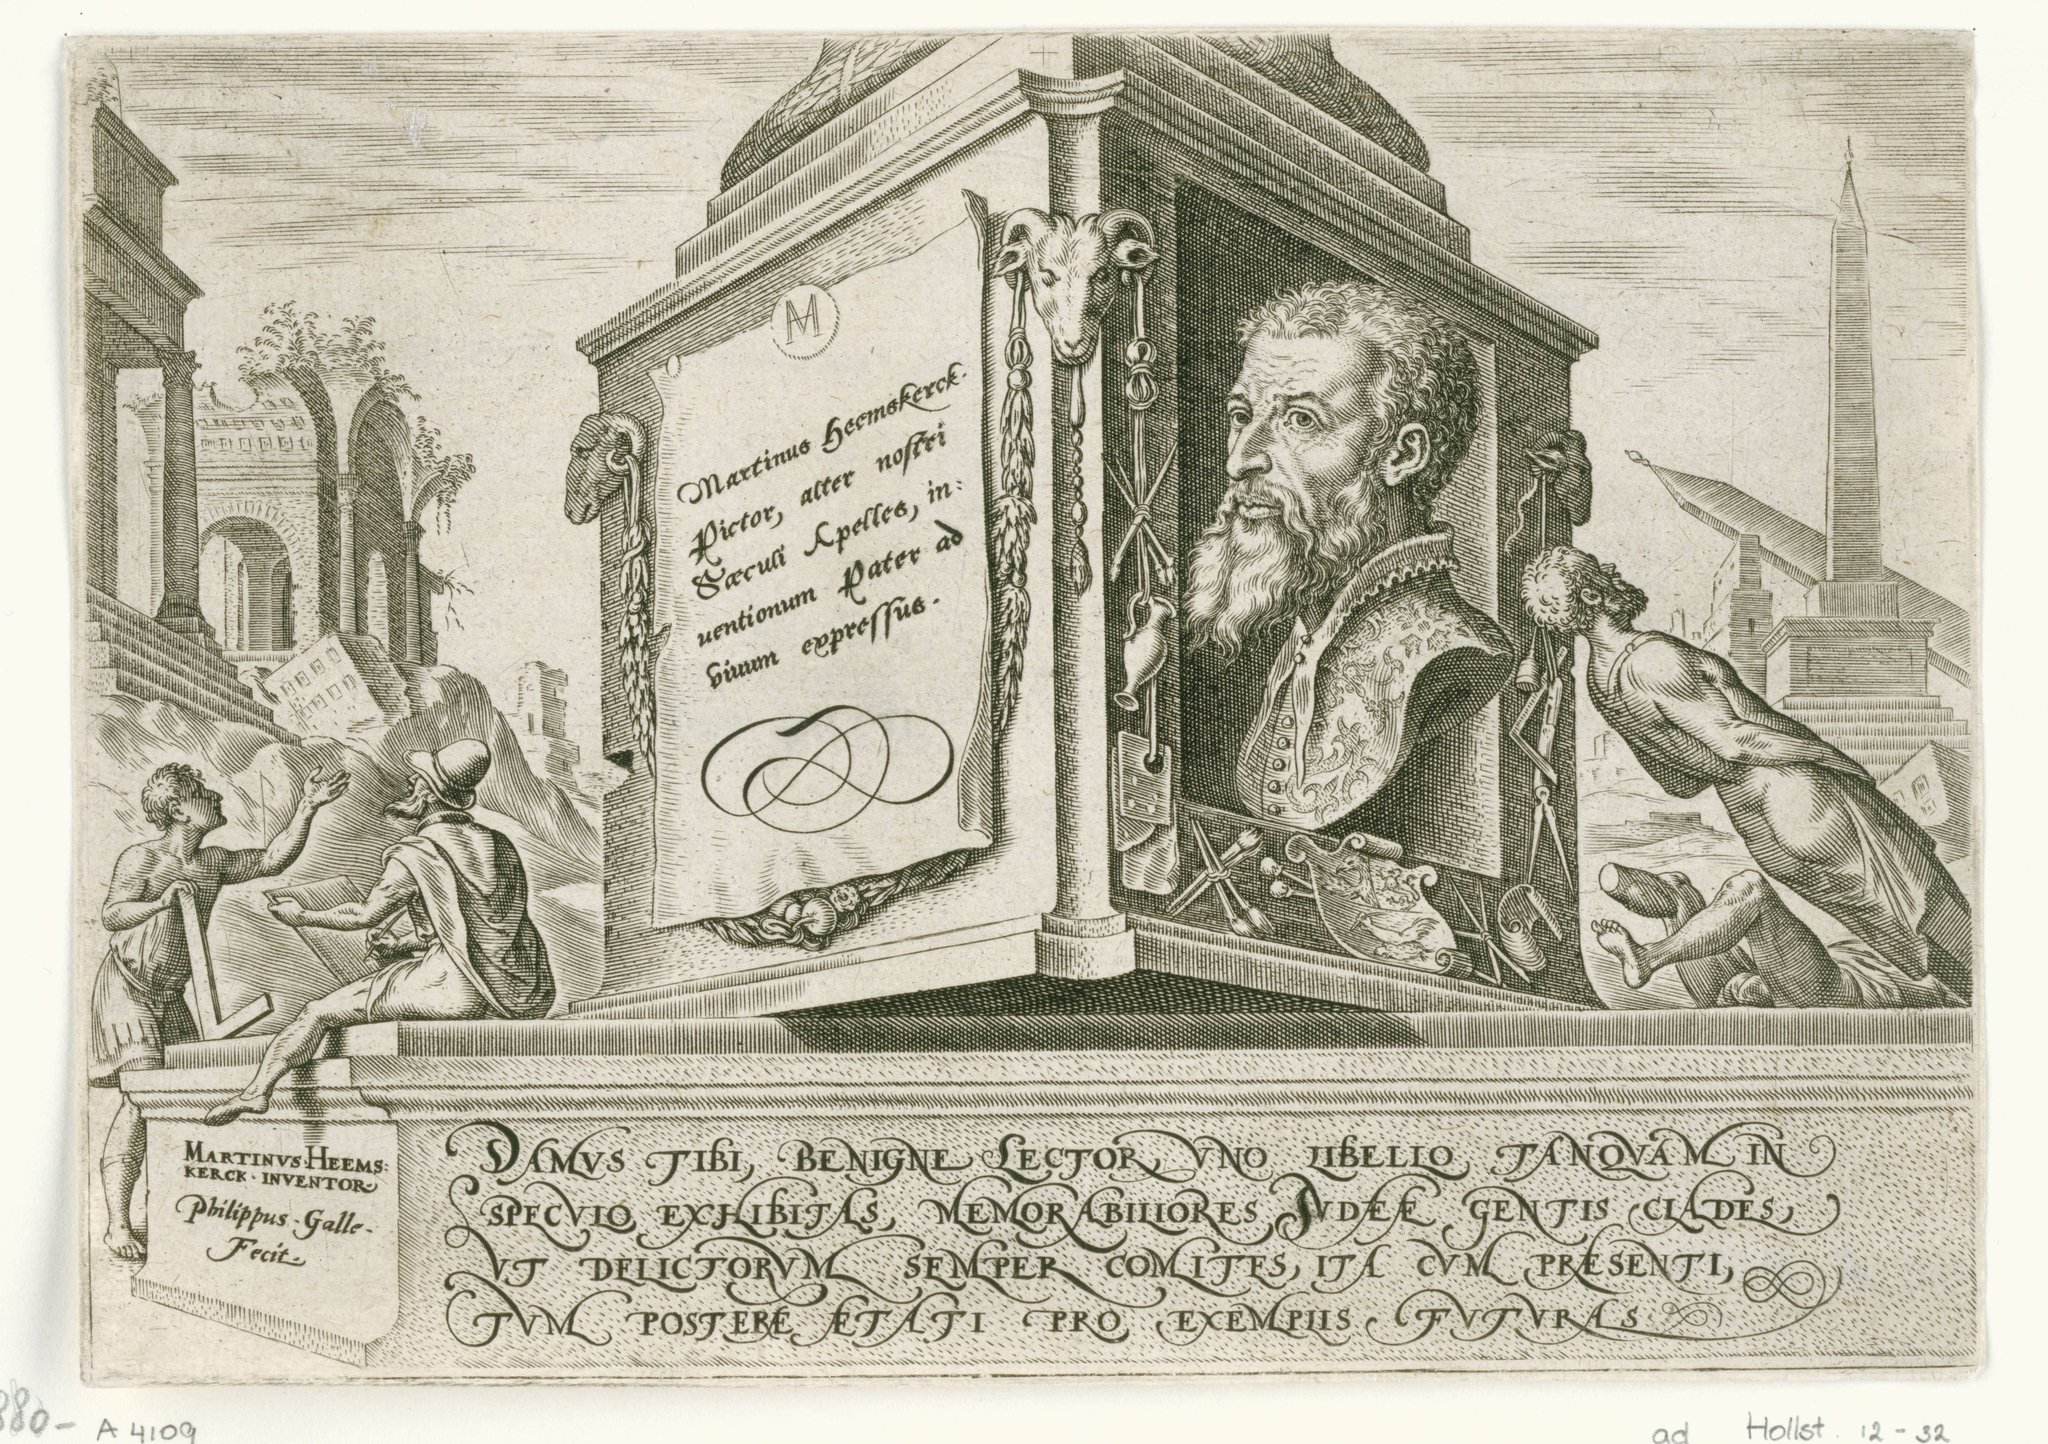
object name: print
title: De onheilsdagen van het Joodse volk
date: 1569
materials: paper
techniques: engraving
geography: haarlem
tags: painter, print maker, draughtsman, maarten van heemskerck, bible, portrait, self-portrait of painter, tools, implements of architect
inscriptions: caption: ‘DAMUS TIBI, BENIGNE LECTOR, UNE LIBELLO TANQUAM IN / SPECULO EXHIBITAS, MEMORABIBIORES JUDAEAE GENTIS CLADES, / UT DELICTORUM SEMPER COMITES, ITA CUM PRAESENTI, / TUM POSTERAE AETATI PRO EXEMPLIS FUTURAS.’, signature: ‘MH / Martinus Heemskerck. / Pictor....expressus’, signature: ‘MARTINUS HEEMS:/ KERCK. INVENTOR / Philippus Galle / Fecit’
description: Titelprent van een serie van 21 genummerde prenten met de onheilsdagen in de geschiedenis van het Joodse volk als morele voorbeelden. Het portret van Maarten van Heemskerck is weergegeven op de sokkel van een zuil, omgeven door attributen van de architectuur en schilderkunst. Links zitten twee architecten, rechts enkele liggende antieke beelden. Op de achtergrond ruïnes van antieke gebouwen en twee obelisken.